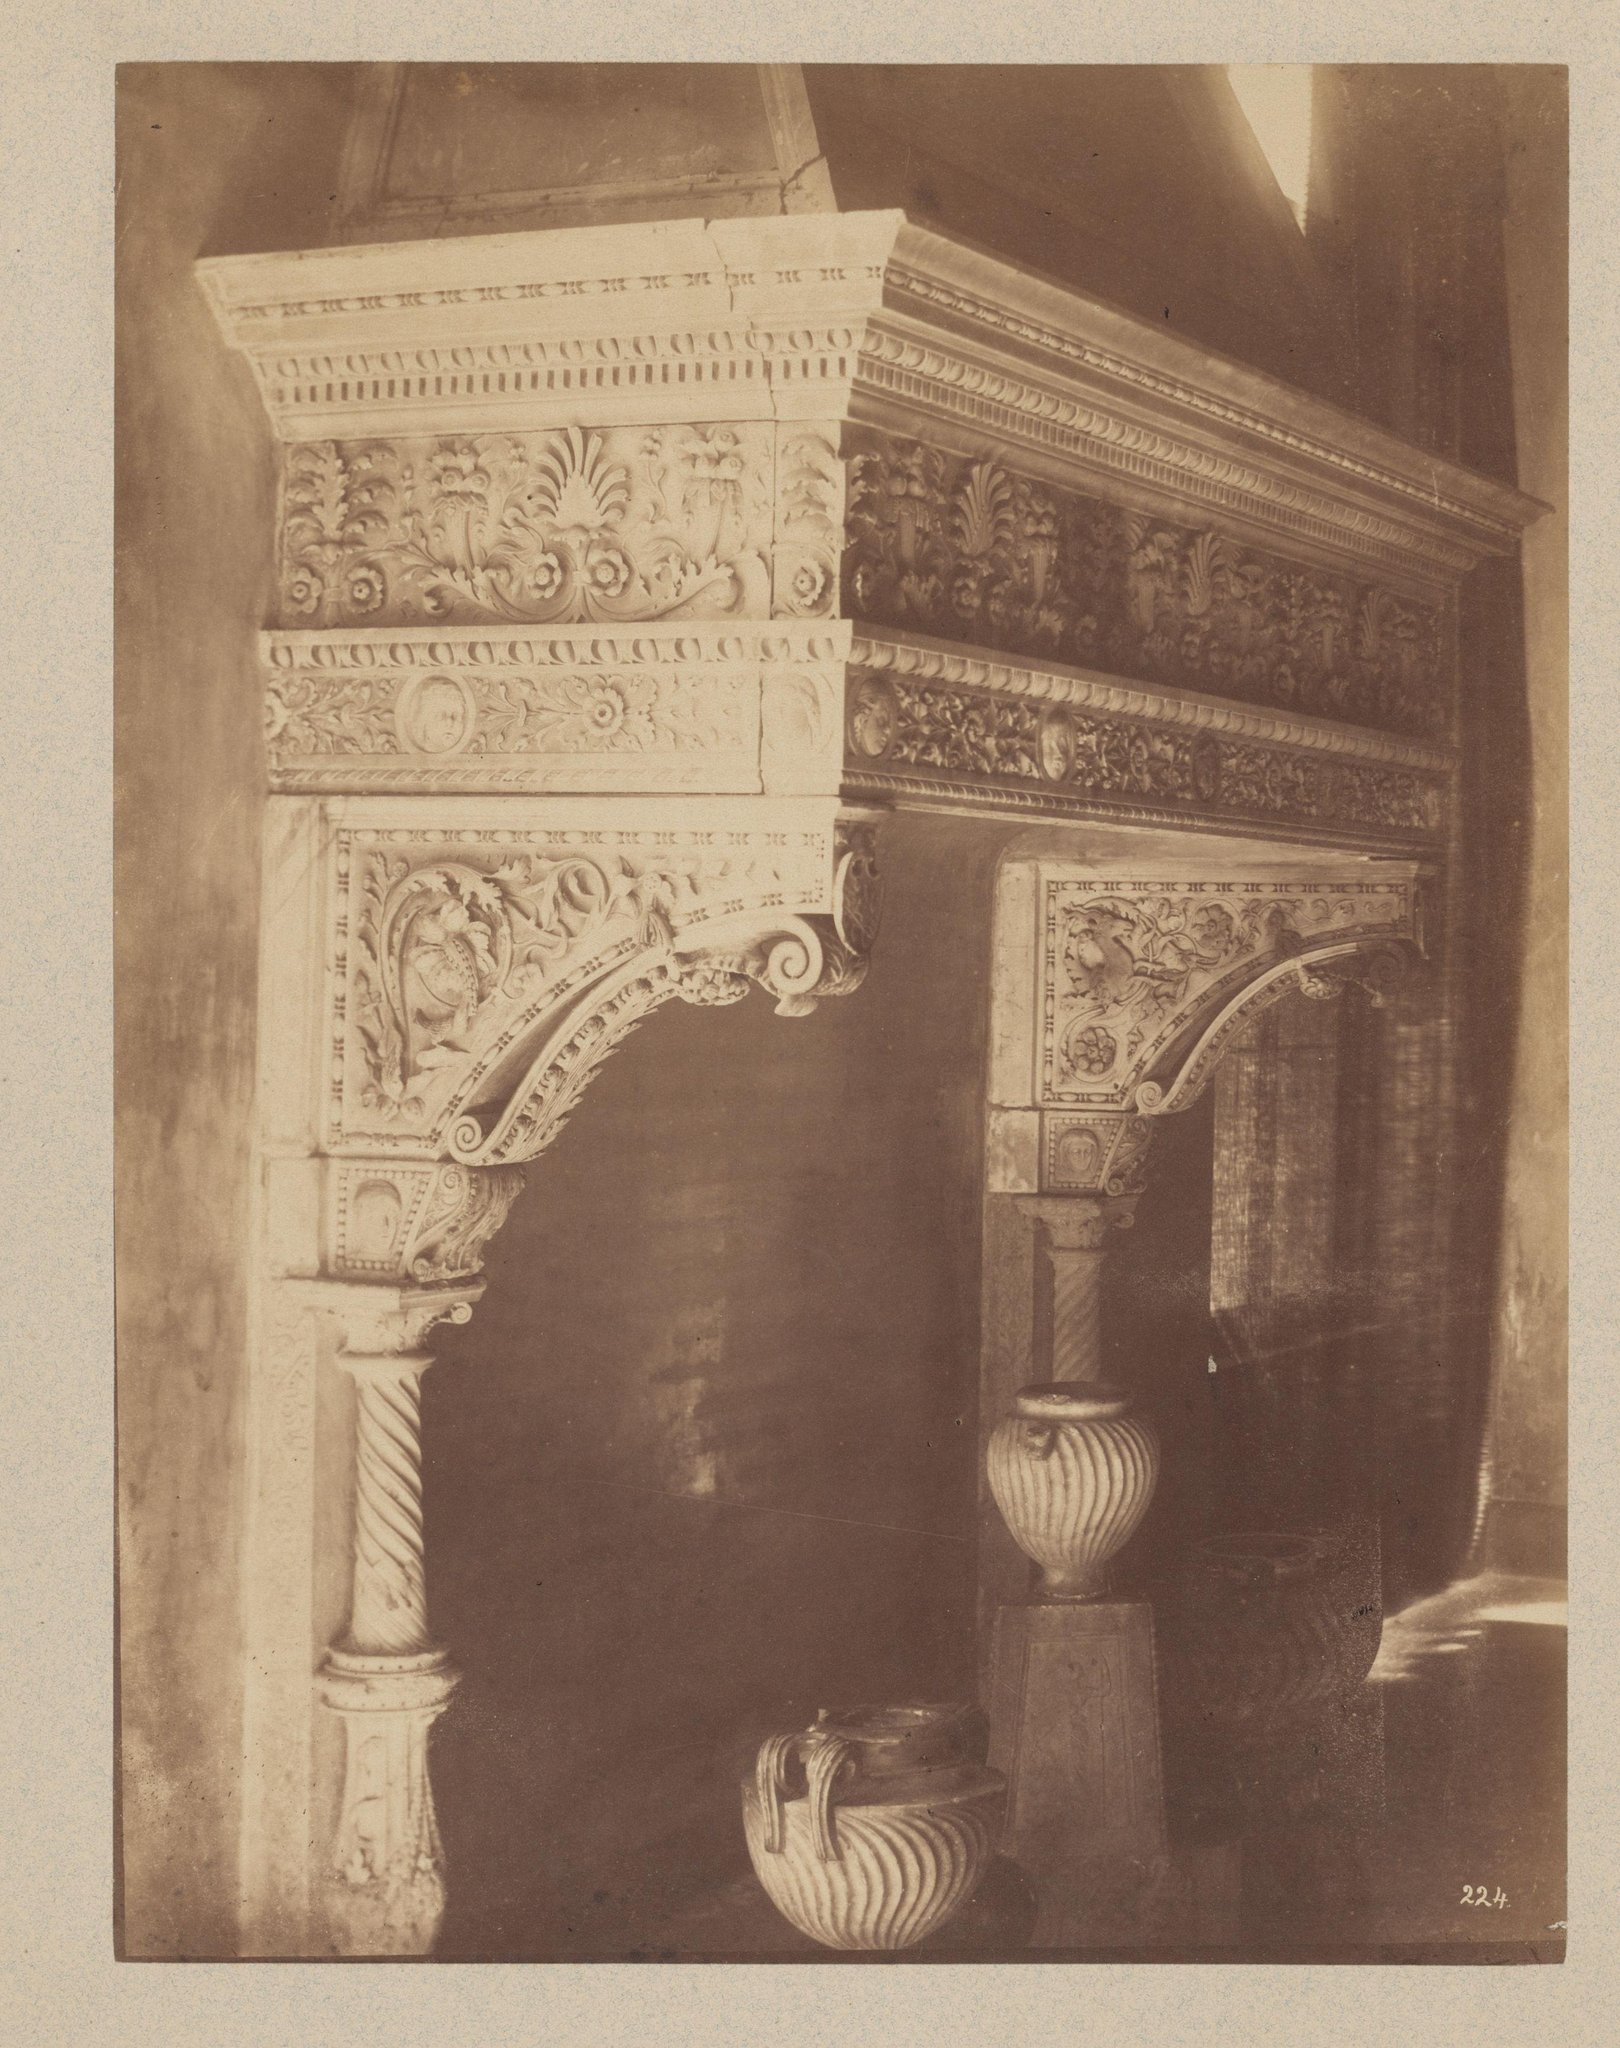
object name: photograph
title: Interieur met schouw met een drietal vazen in Italians palazzo (no. 224)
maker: Anonymous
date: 1880-1900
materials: cardboard, paper, photographic support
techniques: albumen print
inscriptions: : ‘224.’